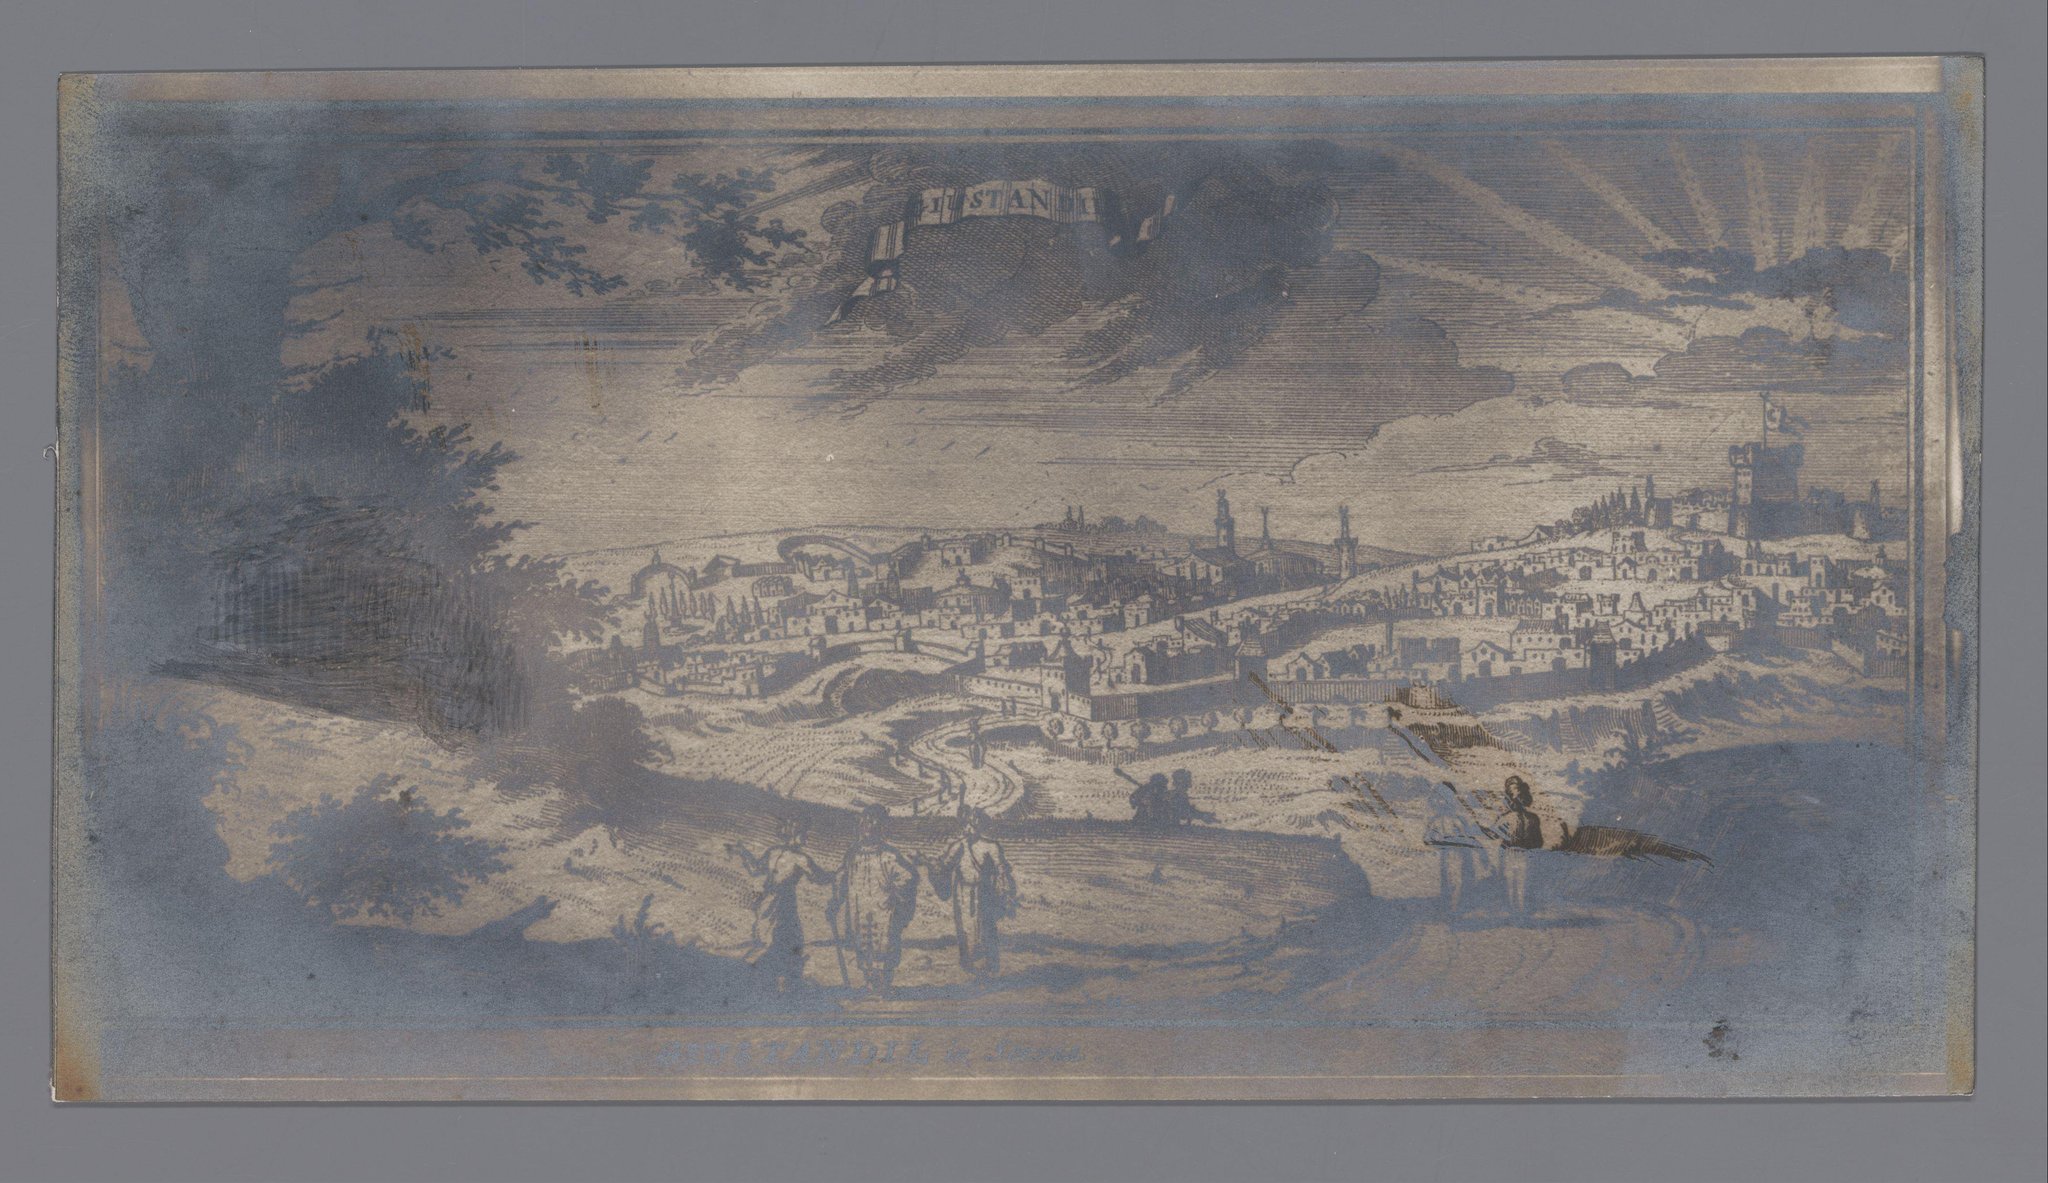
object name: reproduction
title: Fotoreproductie van een prent van de stad Kjoestendil in het huidige Bulgarije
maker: Anonymous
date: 1900-1930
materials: paper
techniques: gelatin silver print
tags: print, e.g.: engraving, etching, lithograph